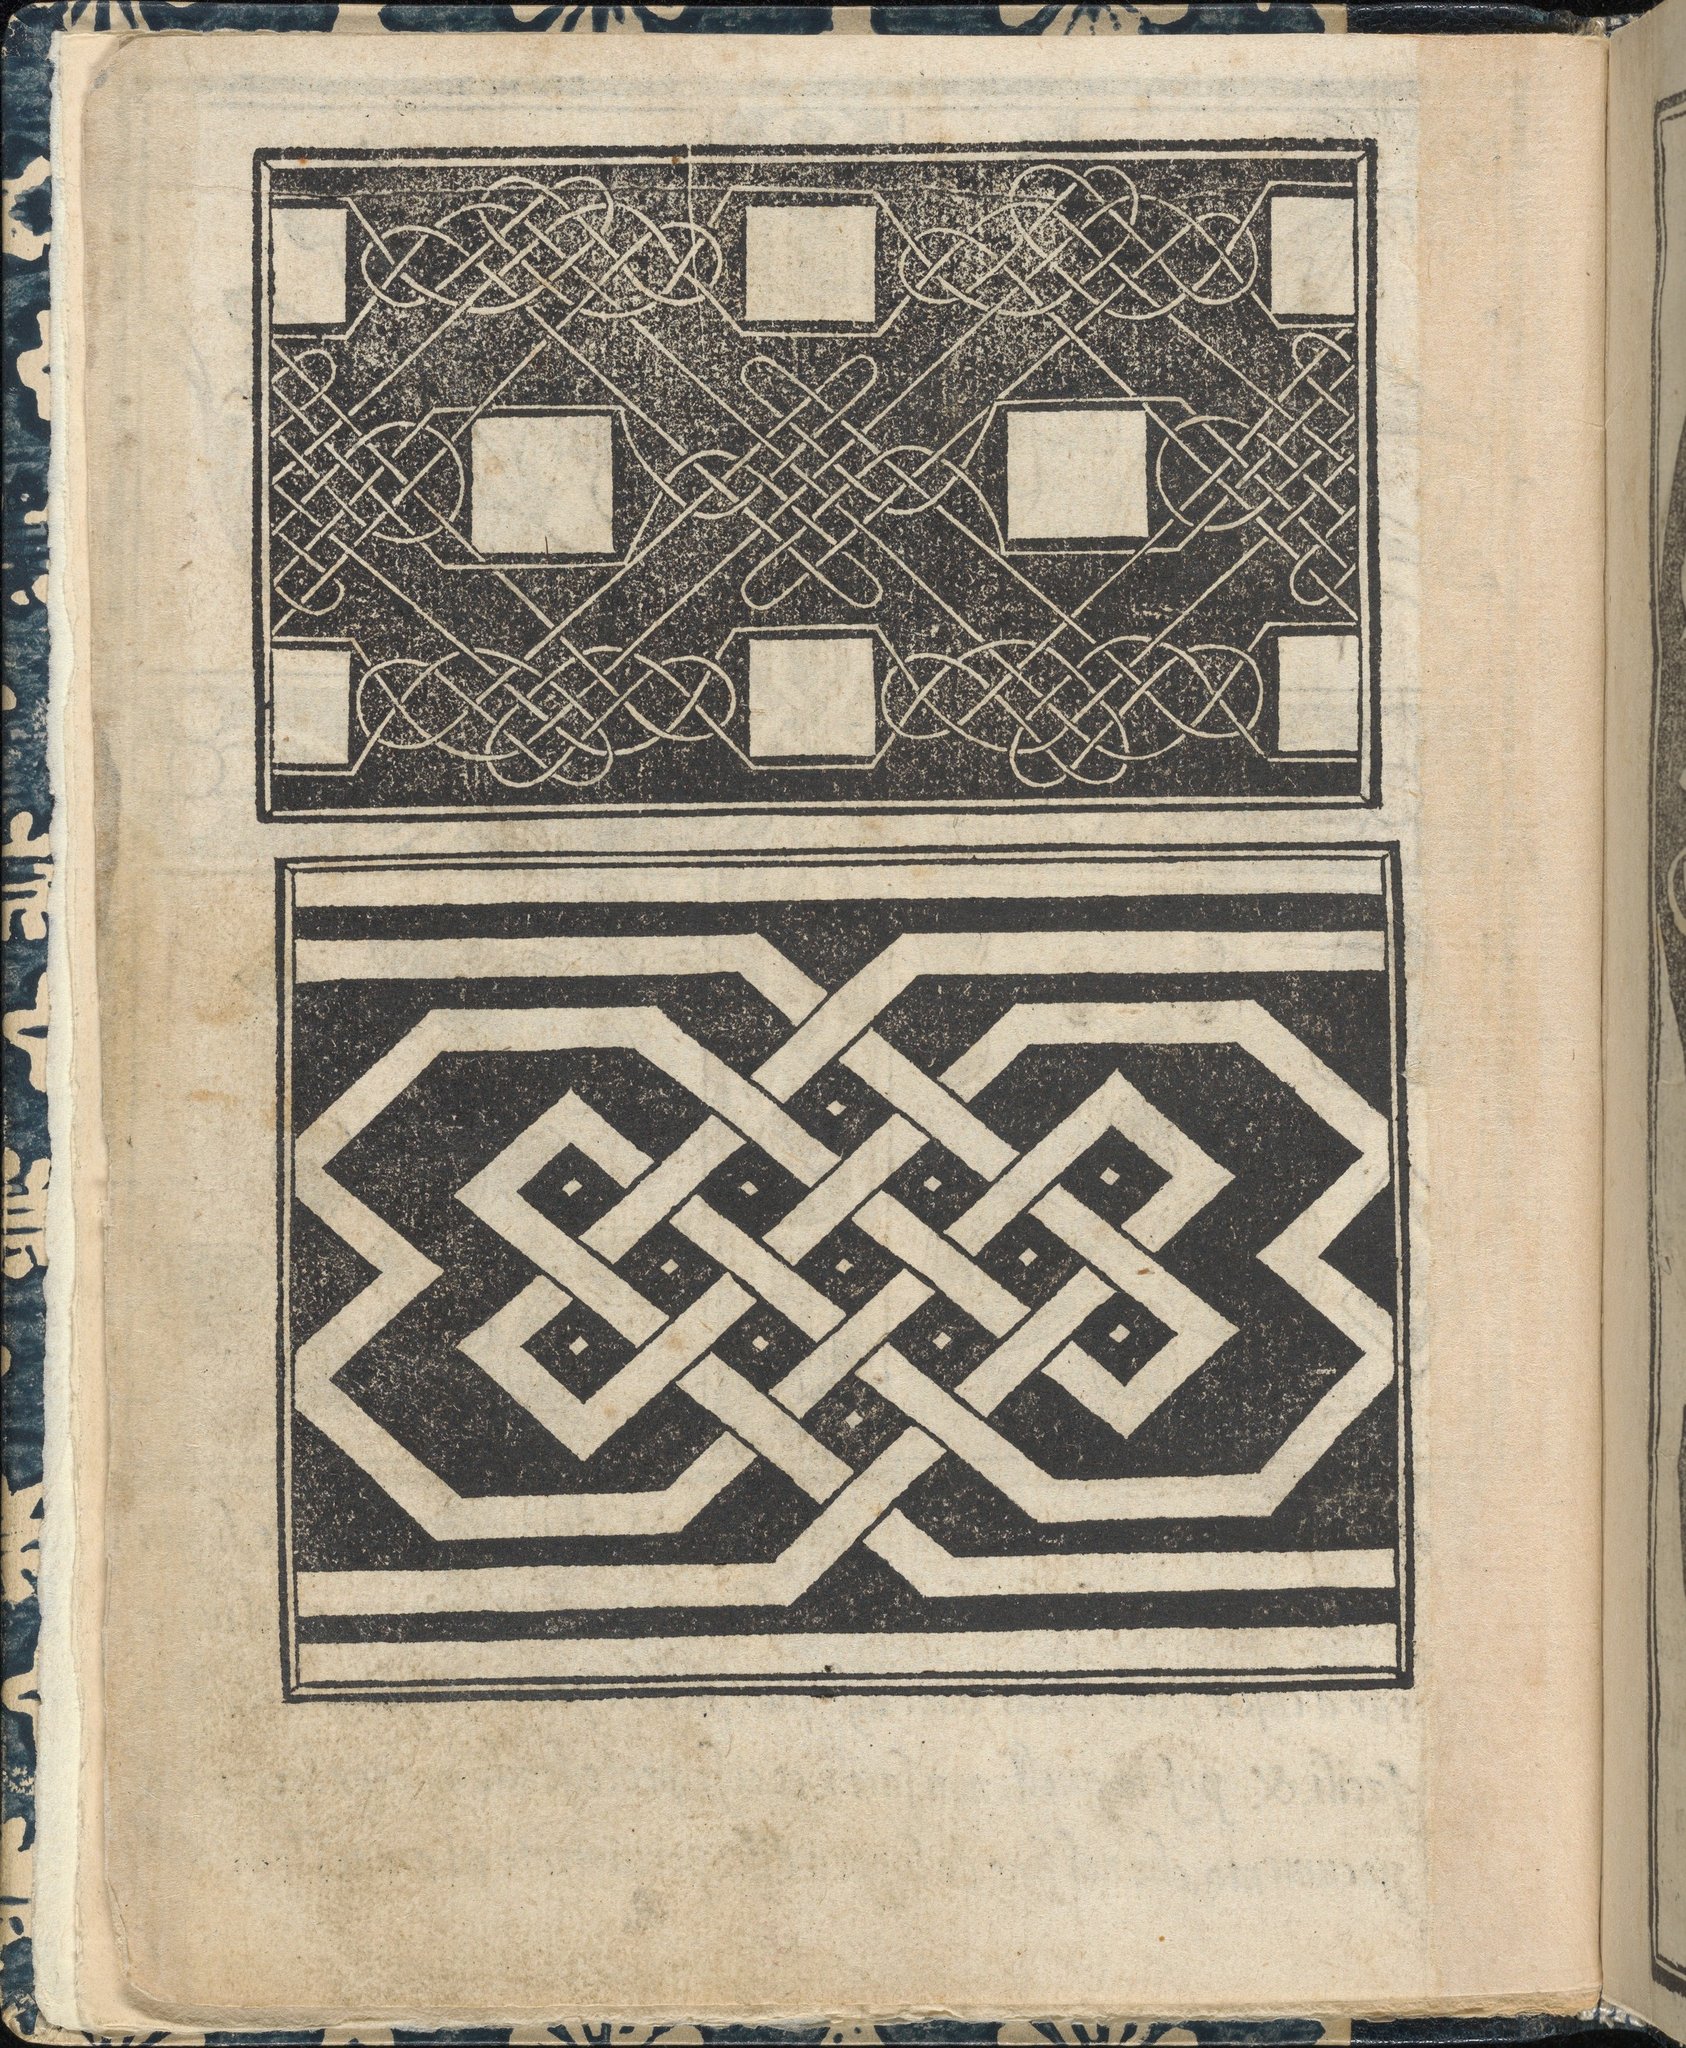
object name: book print ornament architecture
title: Essempio di recammi, page 3 (verso)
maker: giovanni antonio tagliente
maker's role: author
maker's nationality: italian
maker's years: 1465-1528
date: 1530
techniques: woodcut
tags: ornament